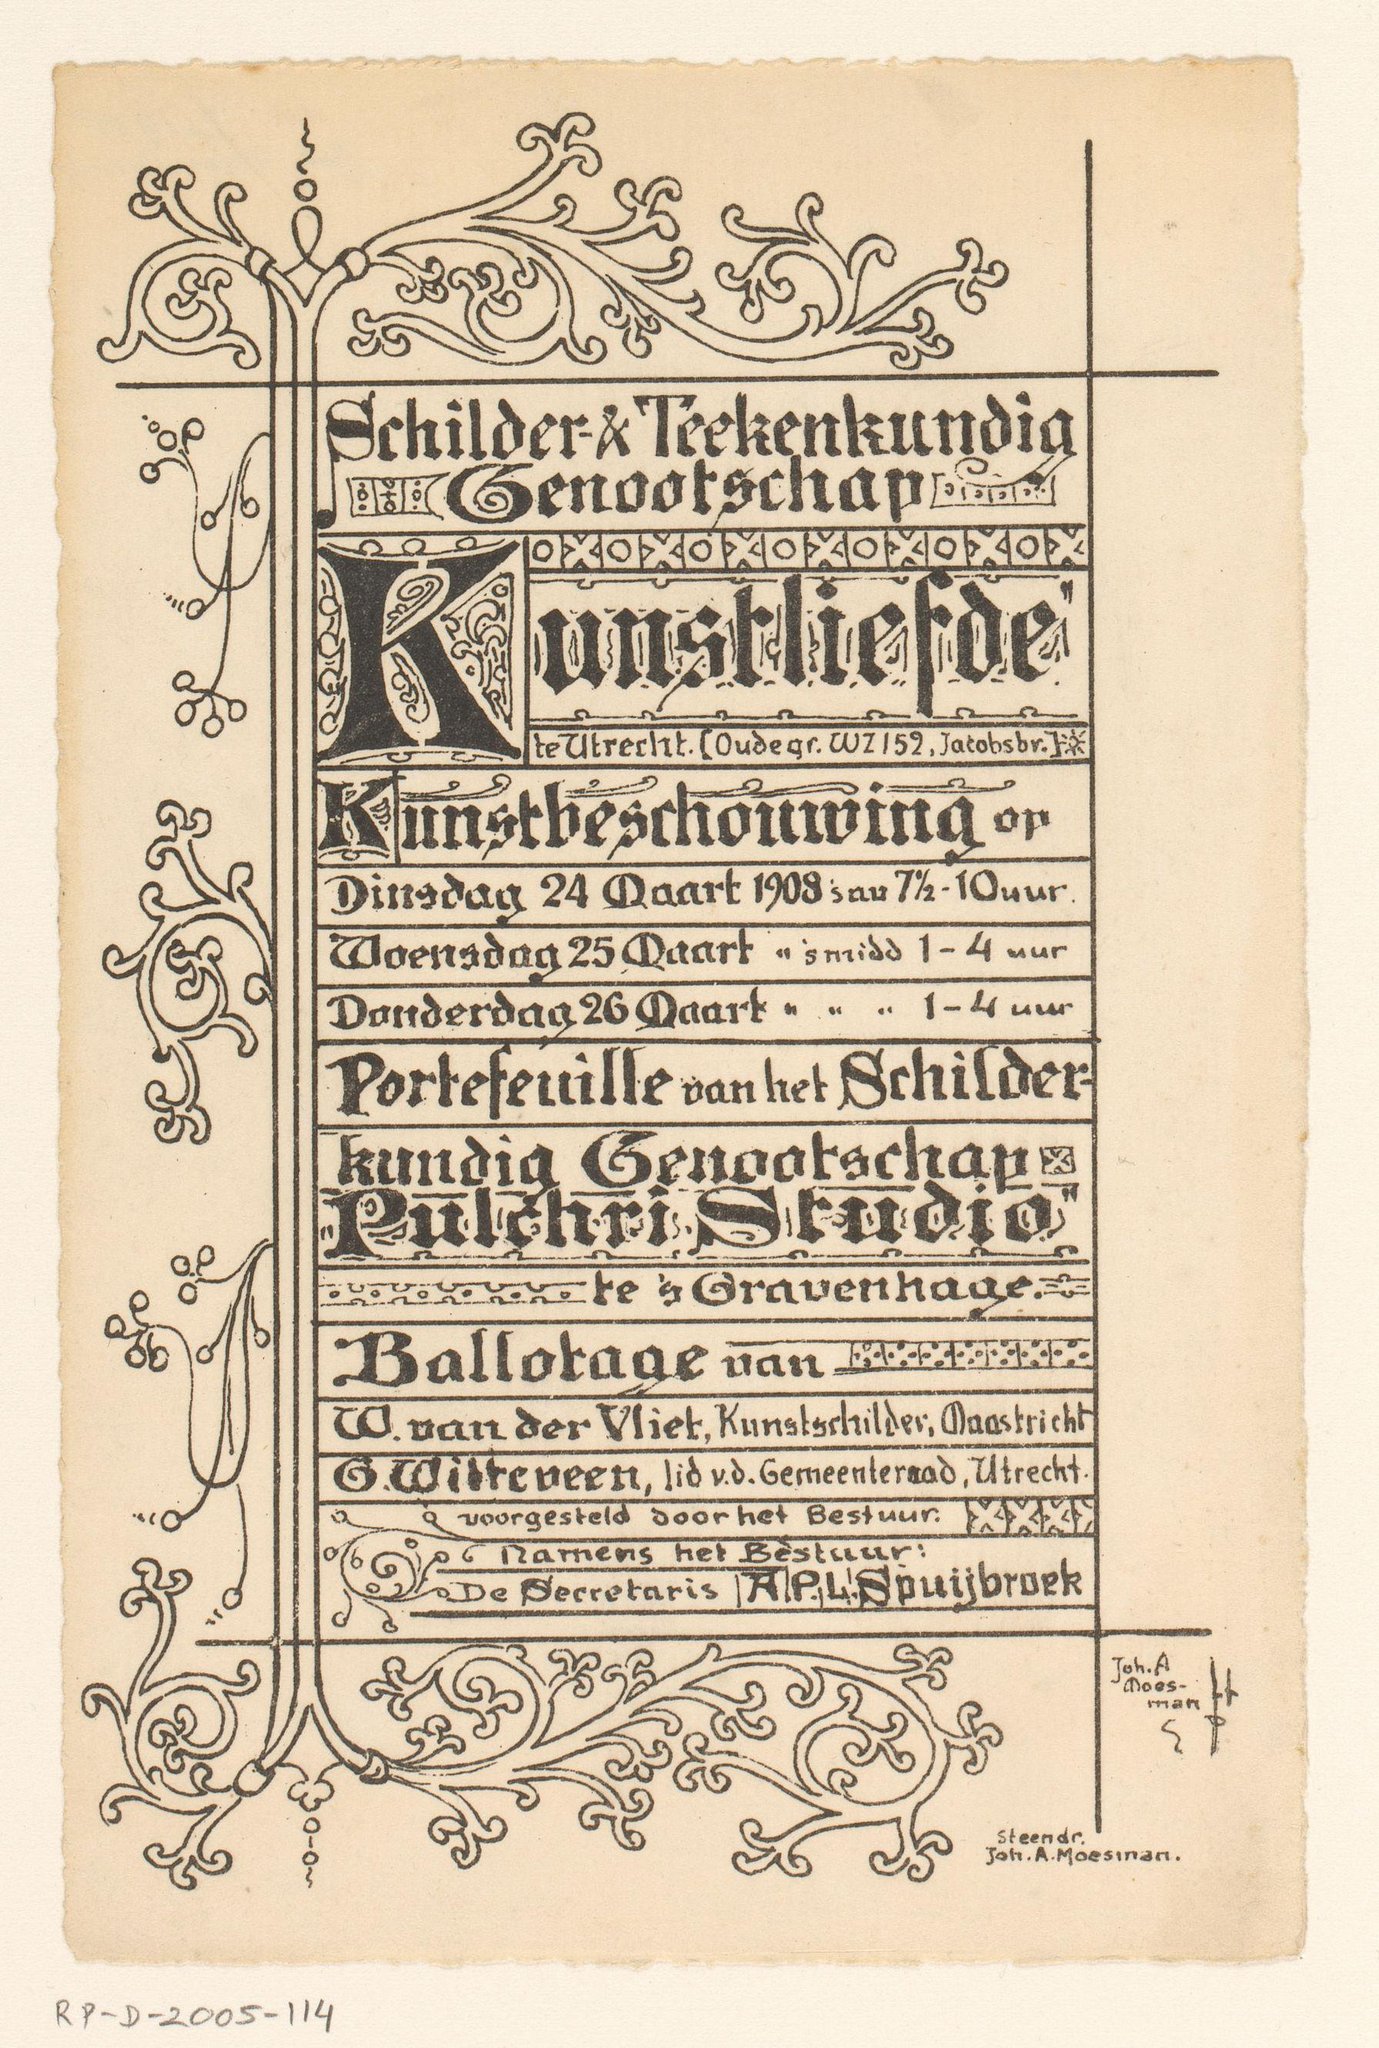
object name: print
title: Uitnodiging van Schilder- en Teekenkundig Genootschap "Kunstliefde" voor een kunstbeschouwing, 24-26 maart 1908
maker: johannes moesman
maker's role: draughtsman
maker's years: 1859-1937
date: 1903-1908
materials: paper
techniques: lithograph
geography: utrecht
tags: criticizing and discussing art, art criticism, circle, club of artists, collecting and exhibiting products of the fine arts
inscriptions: collector's mark: Lugt 2228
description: Blad in de vorm van een middeleeuws manuscript met ornamentele randversiering en tekst. Uitnodiging van Schilder- en Teekenkundig Genootschap "Kunstliefde" voor de kunstbeschouwing op 24-26 1908 van de portefeuille van het Schilderkundig Genootschap Pulchri Studio te Den Haag.